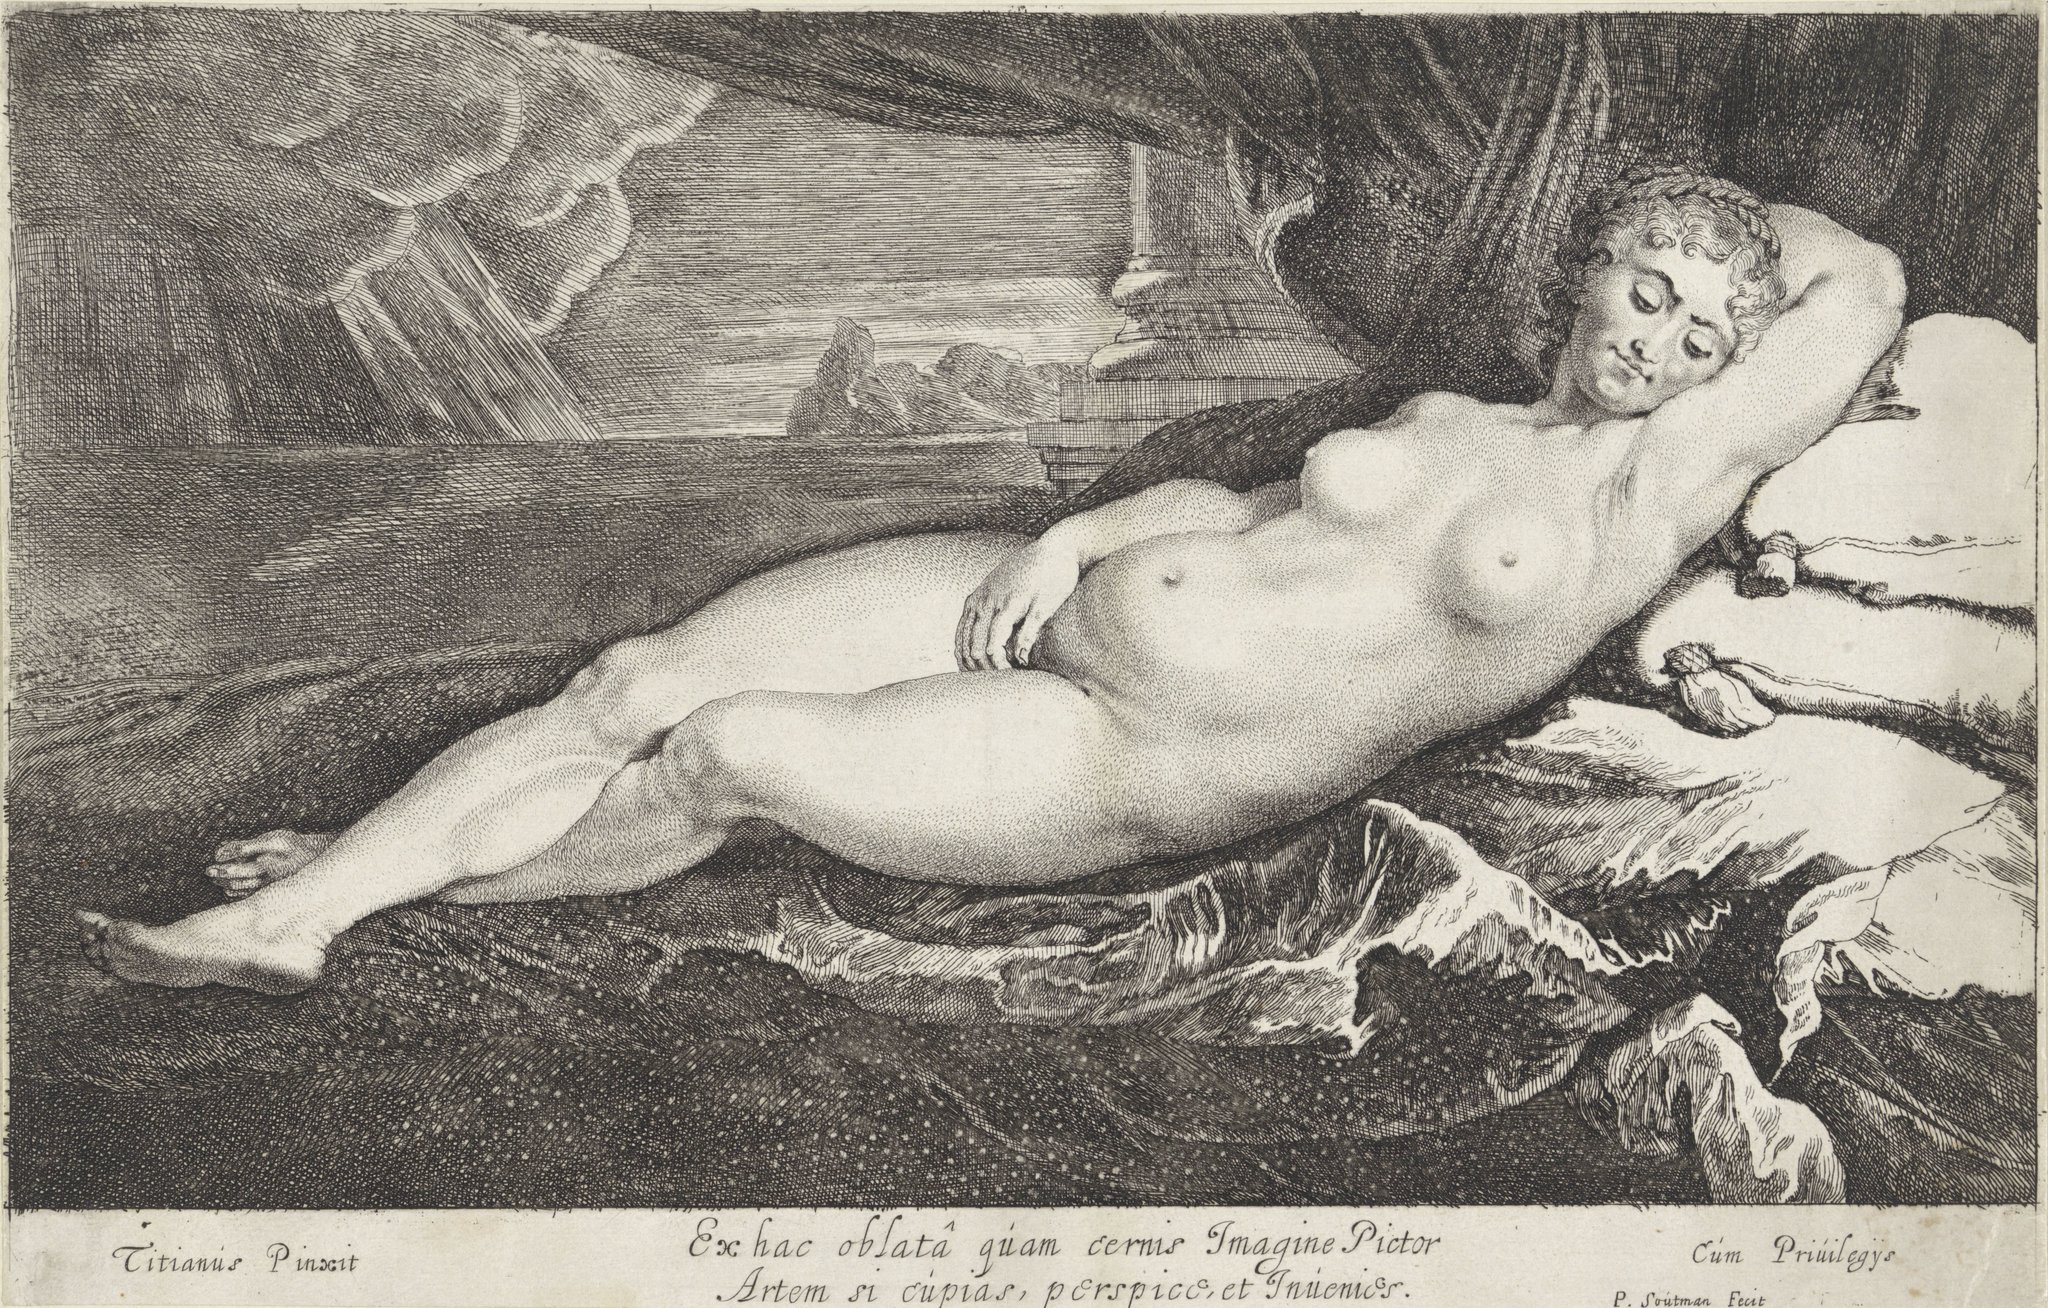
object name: print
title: Venus of Danae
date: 1616-1657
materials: paper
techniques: engraving, etching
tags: venus asleep, (story of) danae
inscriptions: collector's mark: Lugt 240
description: De naakte Venus of Danae ligt te rusten op een bed. Op de achtergrond een zeezicht. Onder de afbeelding twee versregels in het Latijn.